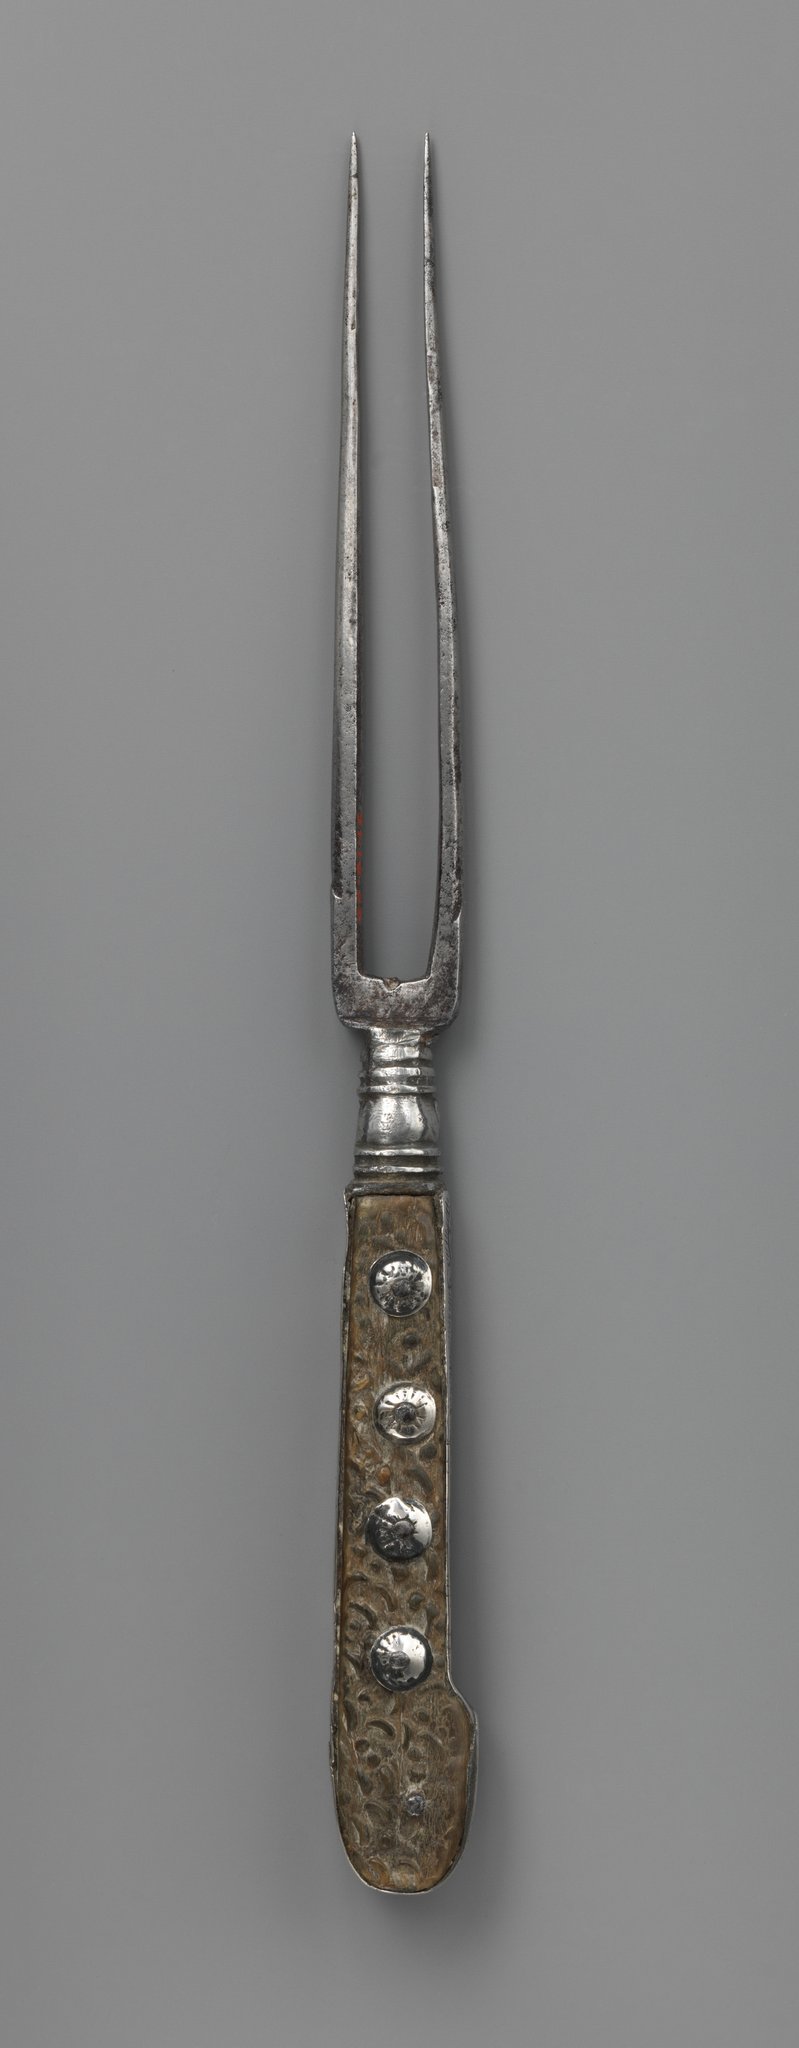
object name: table fork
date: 1787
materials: silver, steel